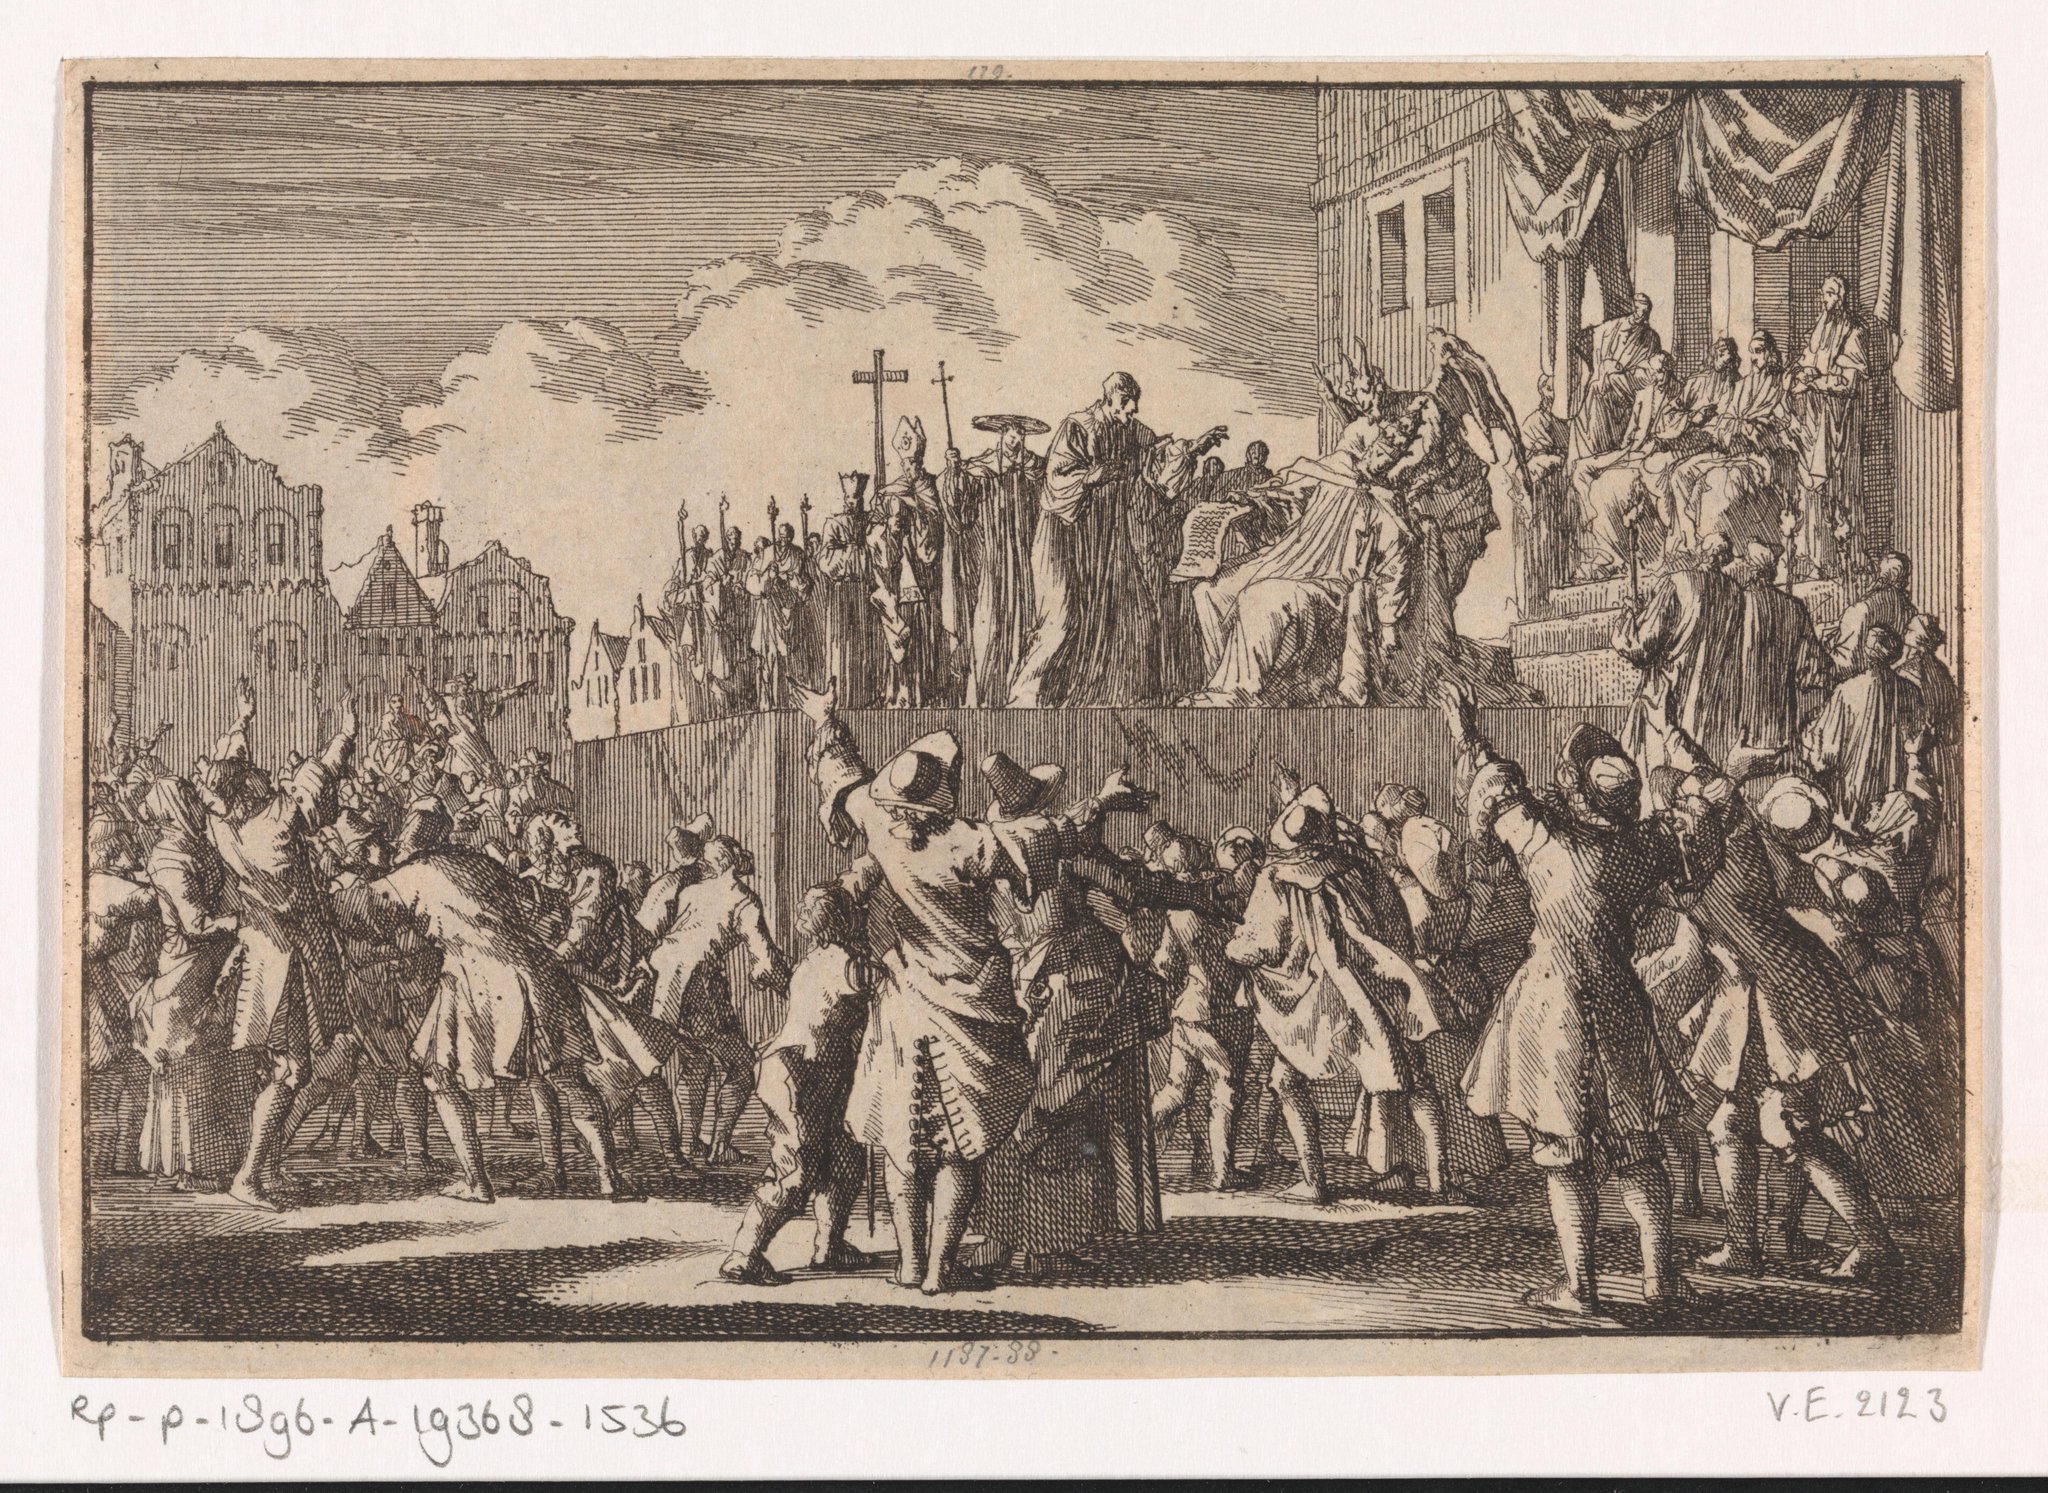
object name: book illustration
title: Straattoneel te Aberdeen waarin de katholieke godsdienst wordt bespot, 1689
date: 1698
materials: paper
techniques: etching, letterpress printing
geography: leiden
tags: theatre, theatrical performance, satyr play, farce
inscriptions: collector's mark: Lugt 2228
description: Illustratie uit: Gottfried, Johann Ludwig. Historische kronyck; vervattende een (...) beschrijvingh der aldergedenckwaerdigste geschiedenissen des weerelds, van den aenvangh der scheppingh tot (...) 1576 (2 delen). Leiden: Pieter van der Aa, 1698, dl. II, p. 1187.